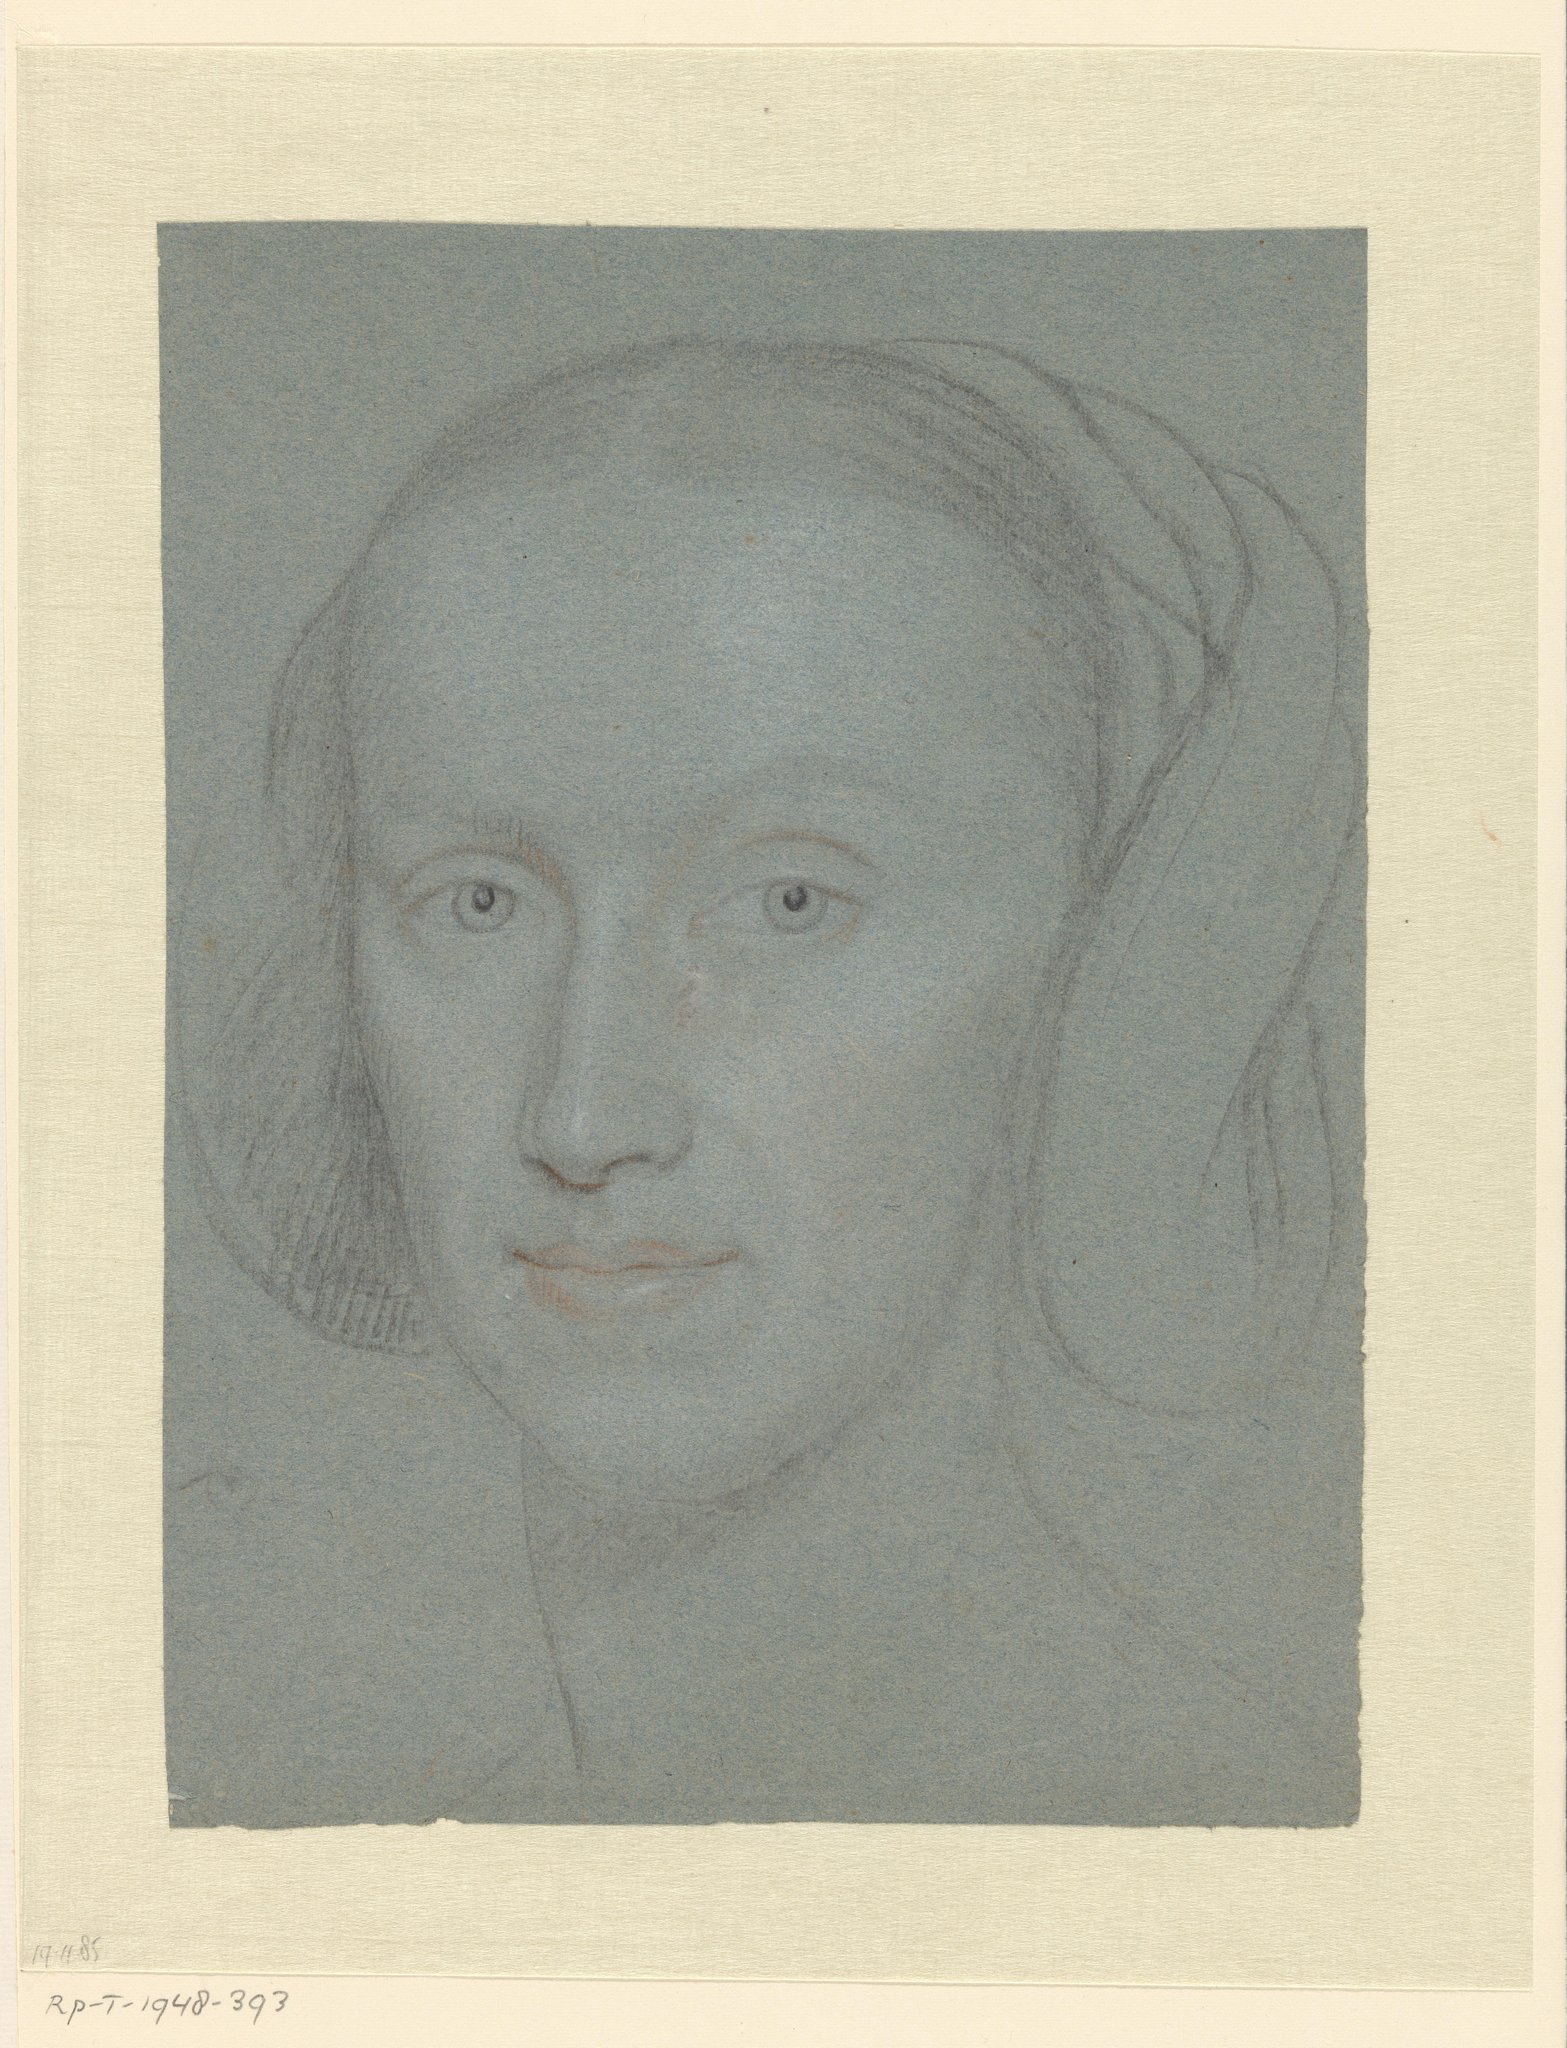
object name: drawing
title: Portret van een vrouw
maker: cornelis janssens van ceulen i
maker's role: draughtsman, painter, print maker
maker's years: 1593-1661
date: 1603-1662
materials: chalk, paper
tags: anonymous historical person portrayed alone (+ head (and shoulders) (portrait))